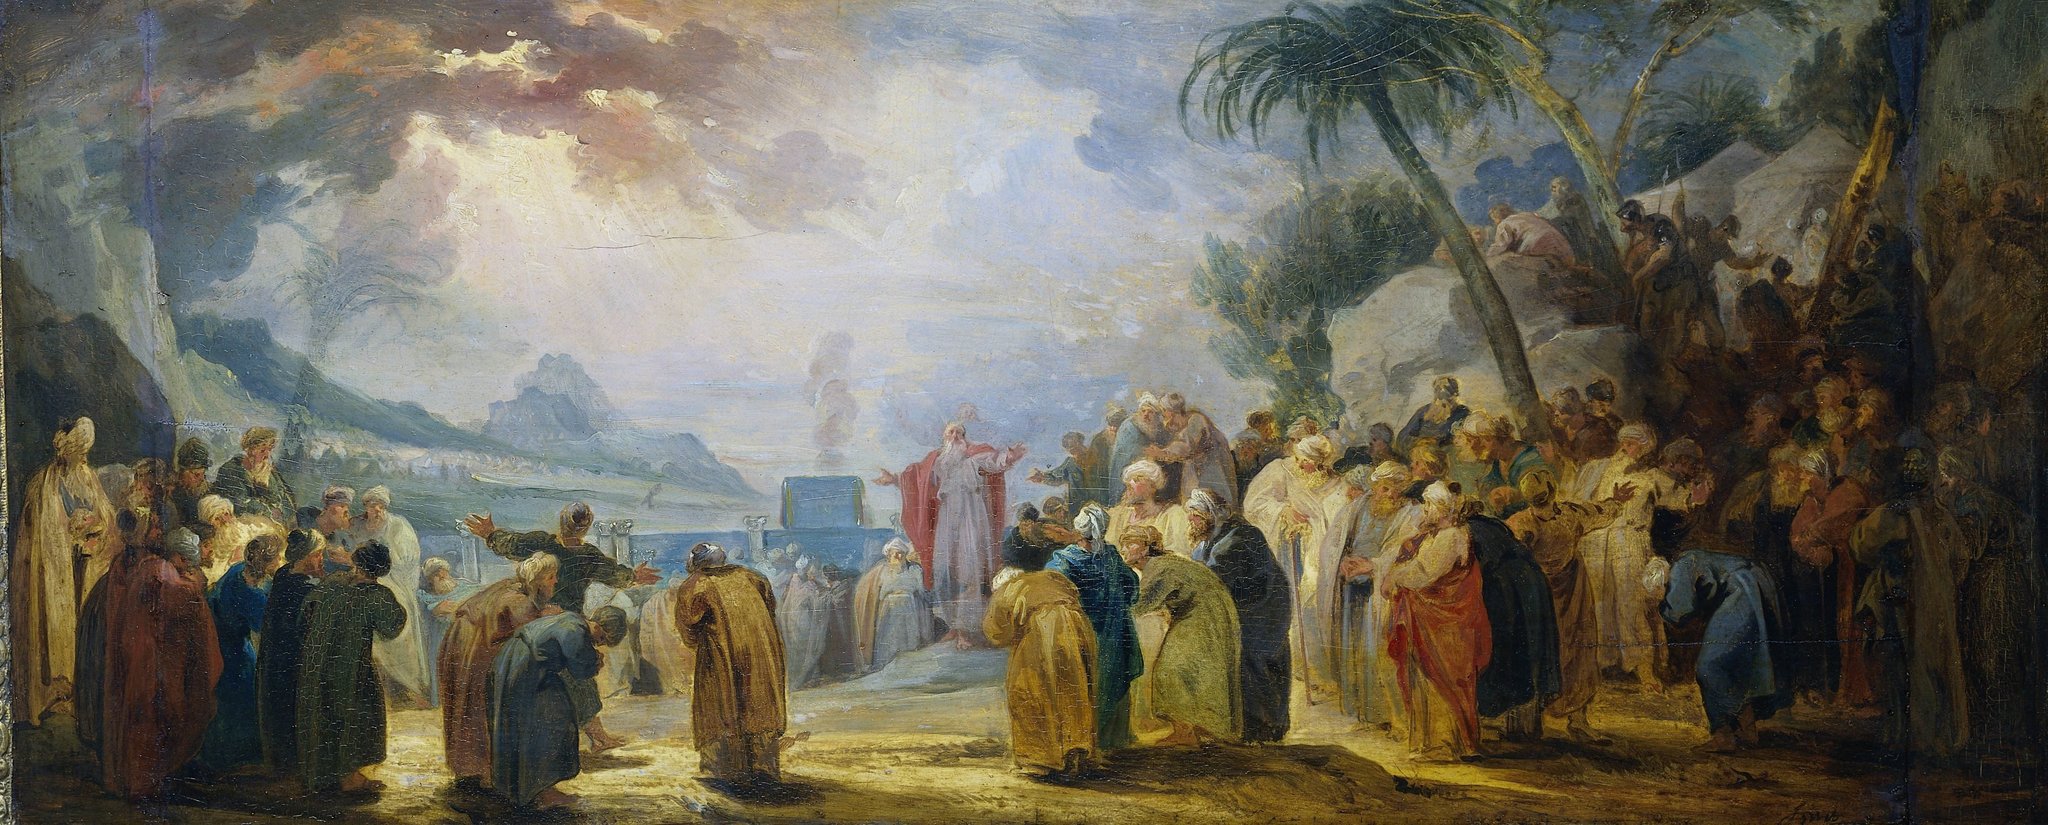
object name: painting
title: Moses Choosing the seventy Elders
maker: jacob de wit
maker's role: draughtsman, painter, print maker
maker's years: 1695-1754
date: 1736-1737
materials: oil, panel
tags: moses choosing judges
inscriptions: signature: ‘J.d.Wit’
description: Mozes verkiest de zeventig oudsten. In een vlakte in de woestijn staat Mozes met uitgestrekte armen tussen de Israëlieten. Op de achtergrond het tabernakel of ark des verbonds, rechts palmbomen en tenten. Modello voor het grote schilderij in de vroedschapskamer van het voormalige Stadhuis op de Dam.